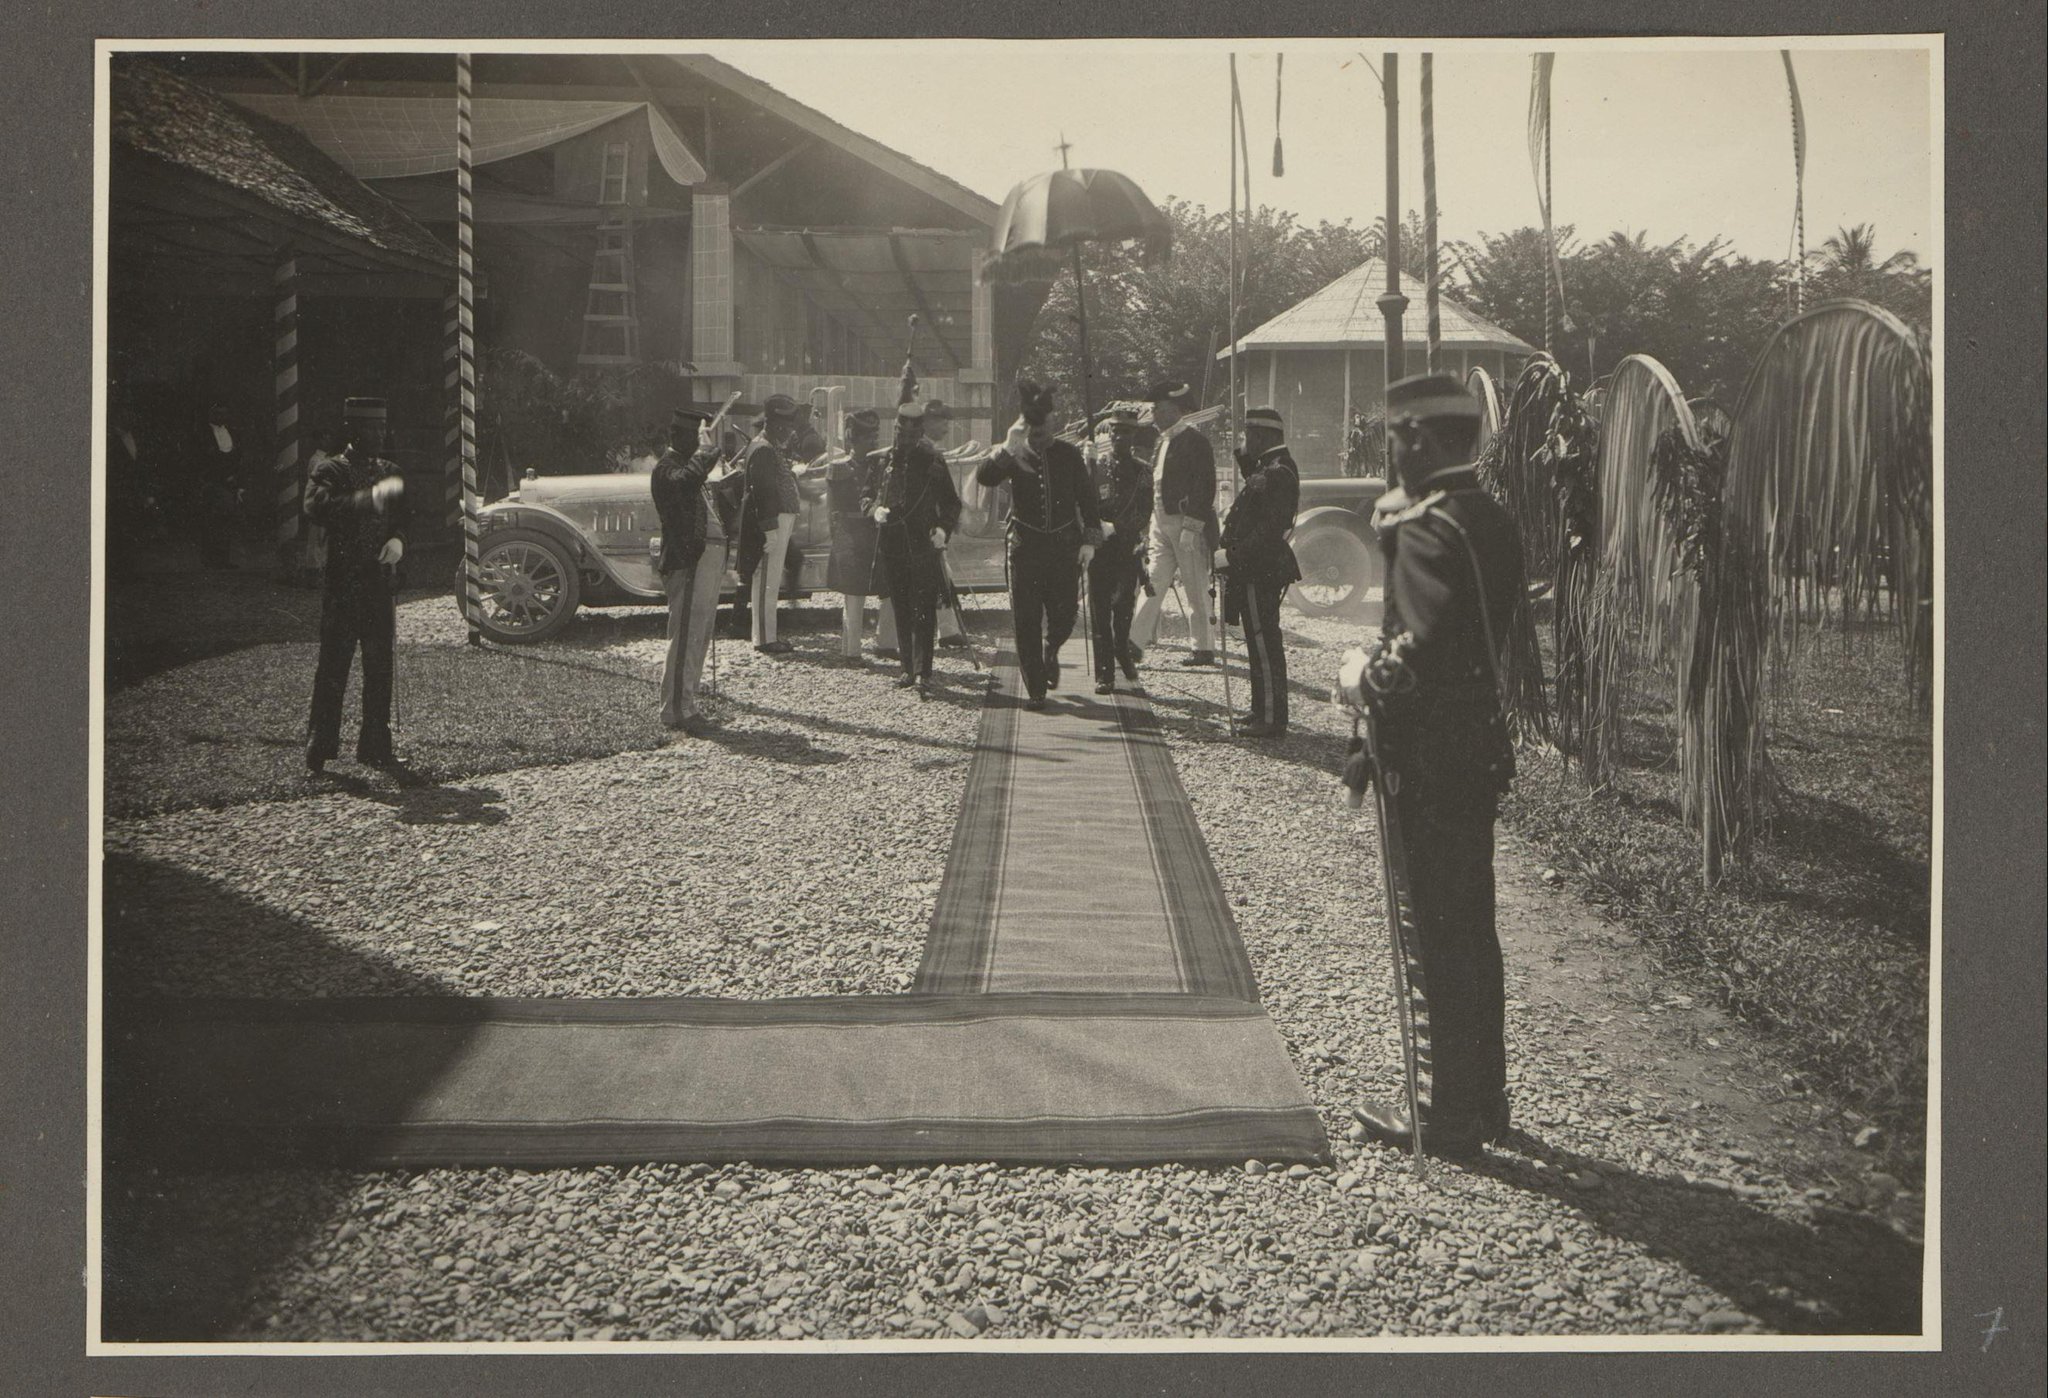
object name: photograph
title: Bezoek van een Nederlandse hoogwaardigheidsbekleder aan het hof van de Sultan van Langkat te Sumatra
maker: Anonymous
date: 1919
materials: photographic support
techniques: gelatin silver print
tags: other sovereign, automobile, sumatra